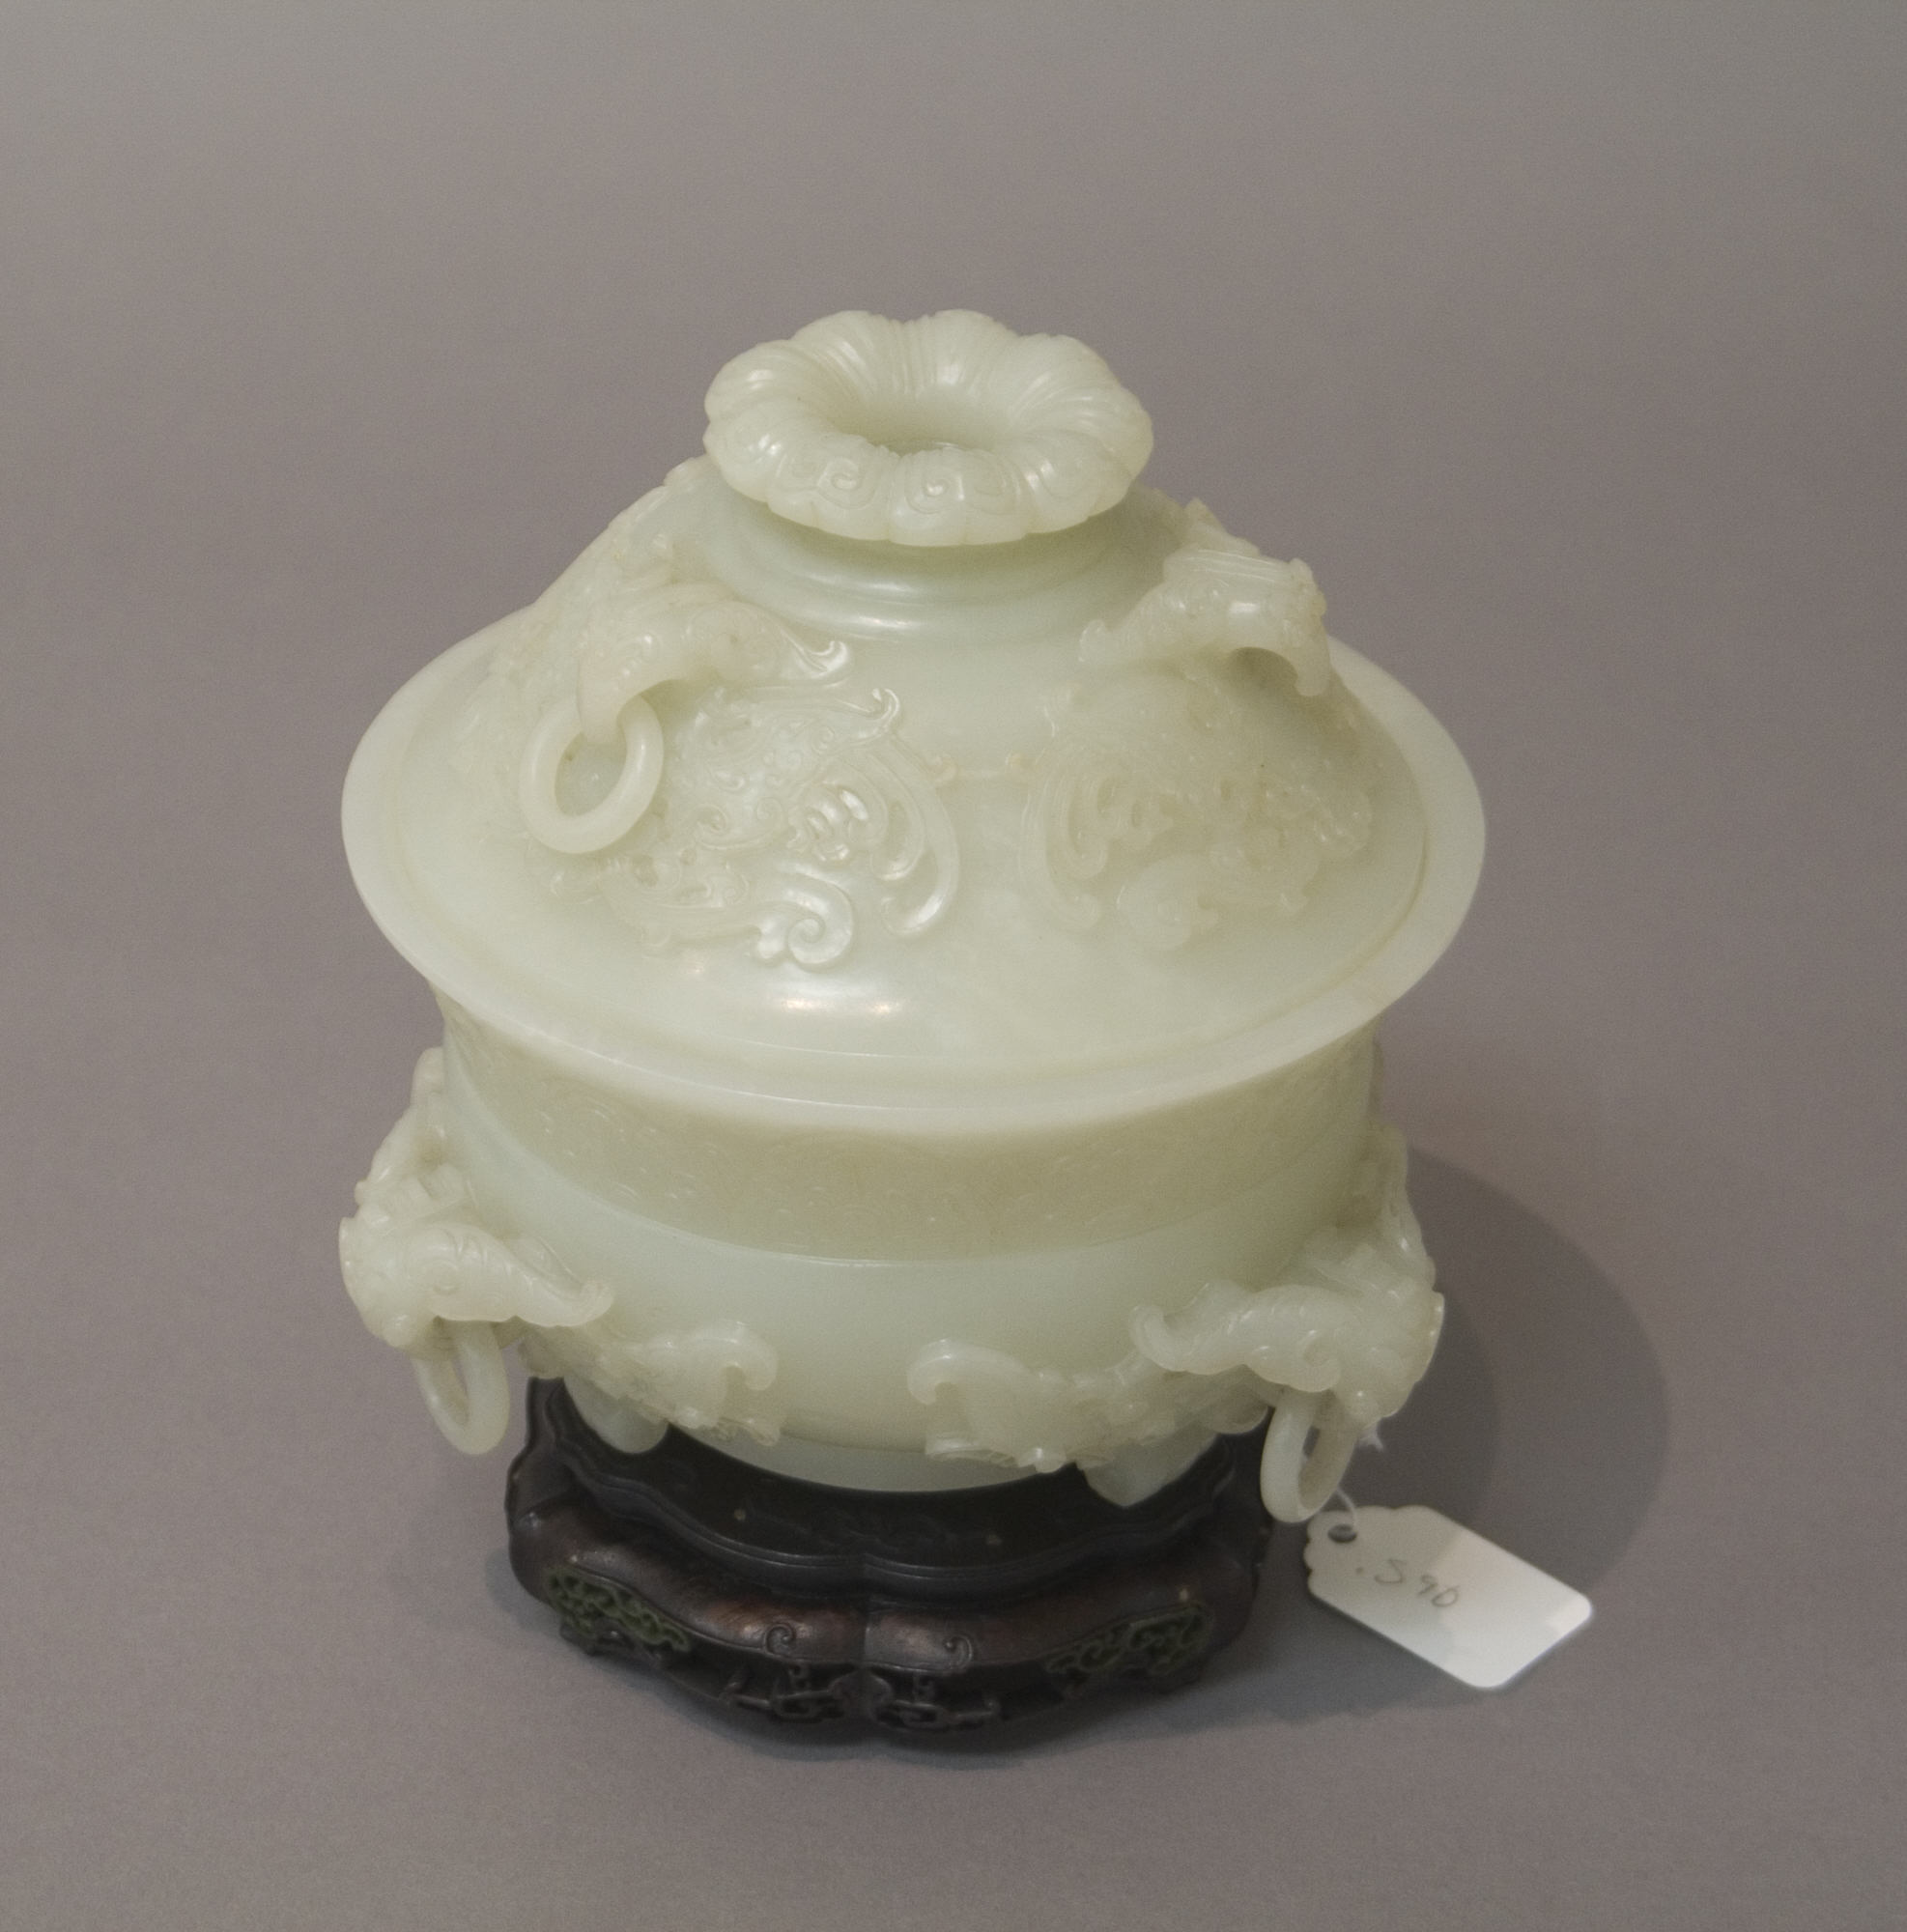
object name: incense burner with cover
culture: chinese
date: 1736-1795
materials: jade